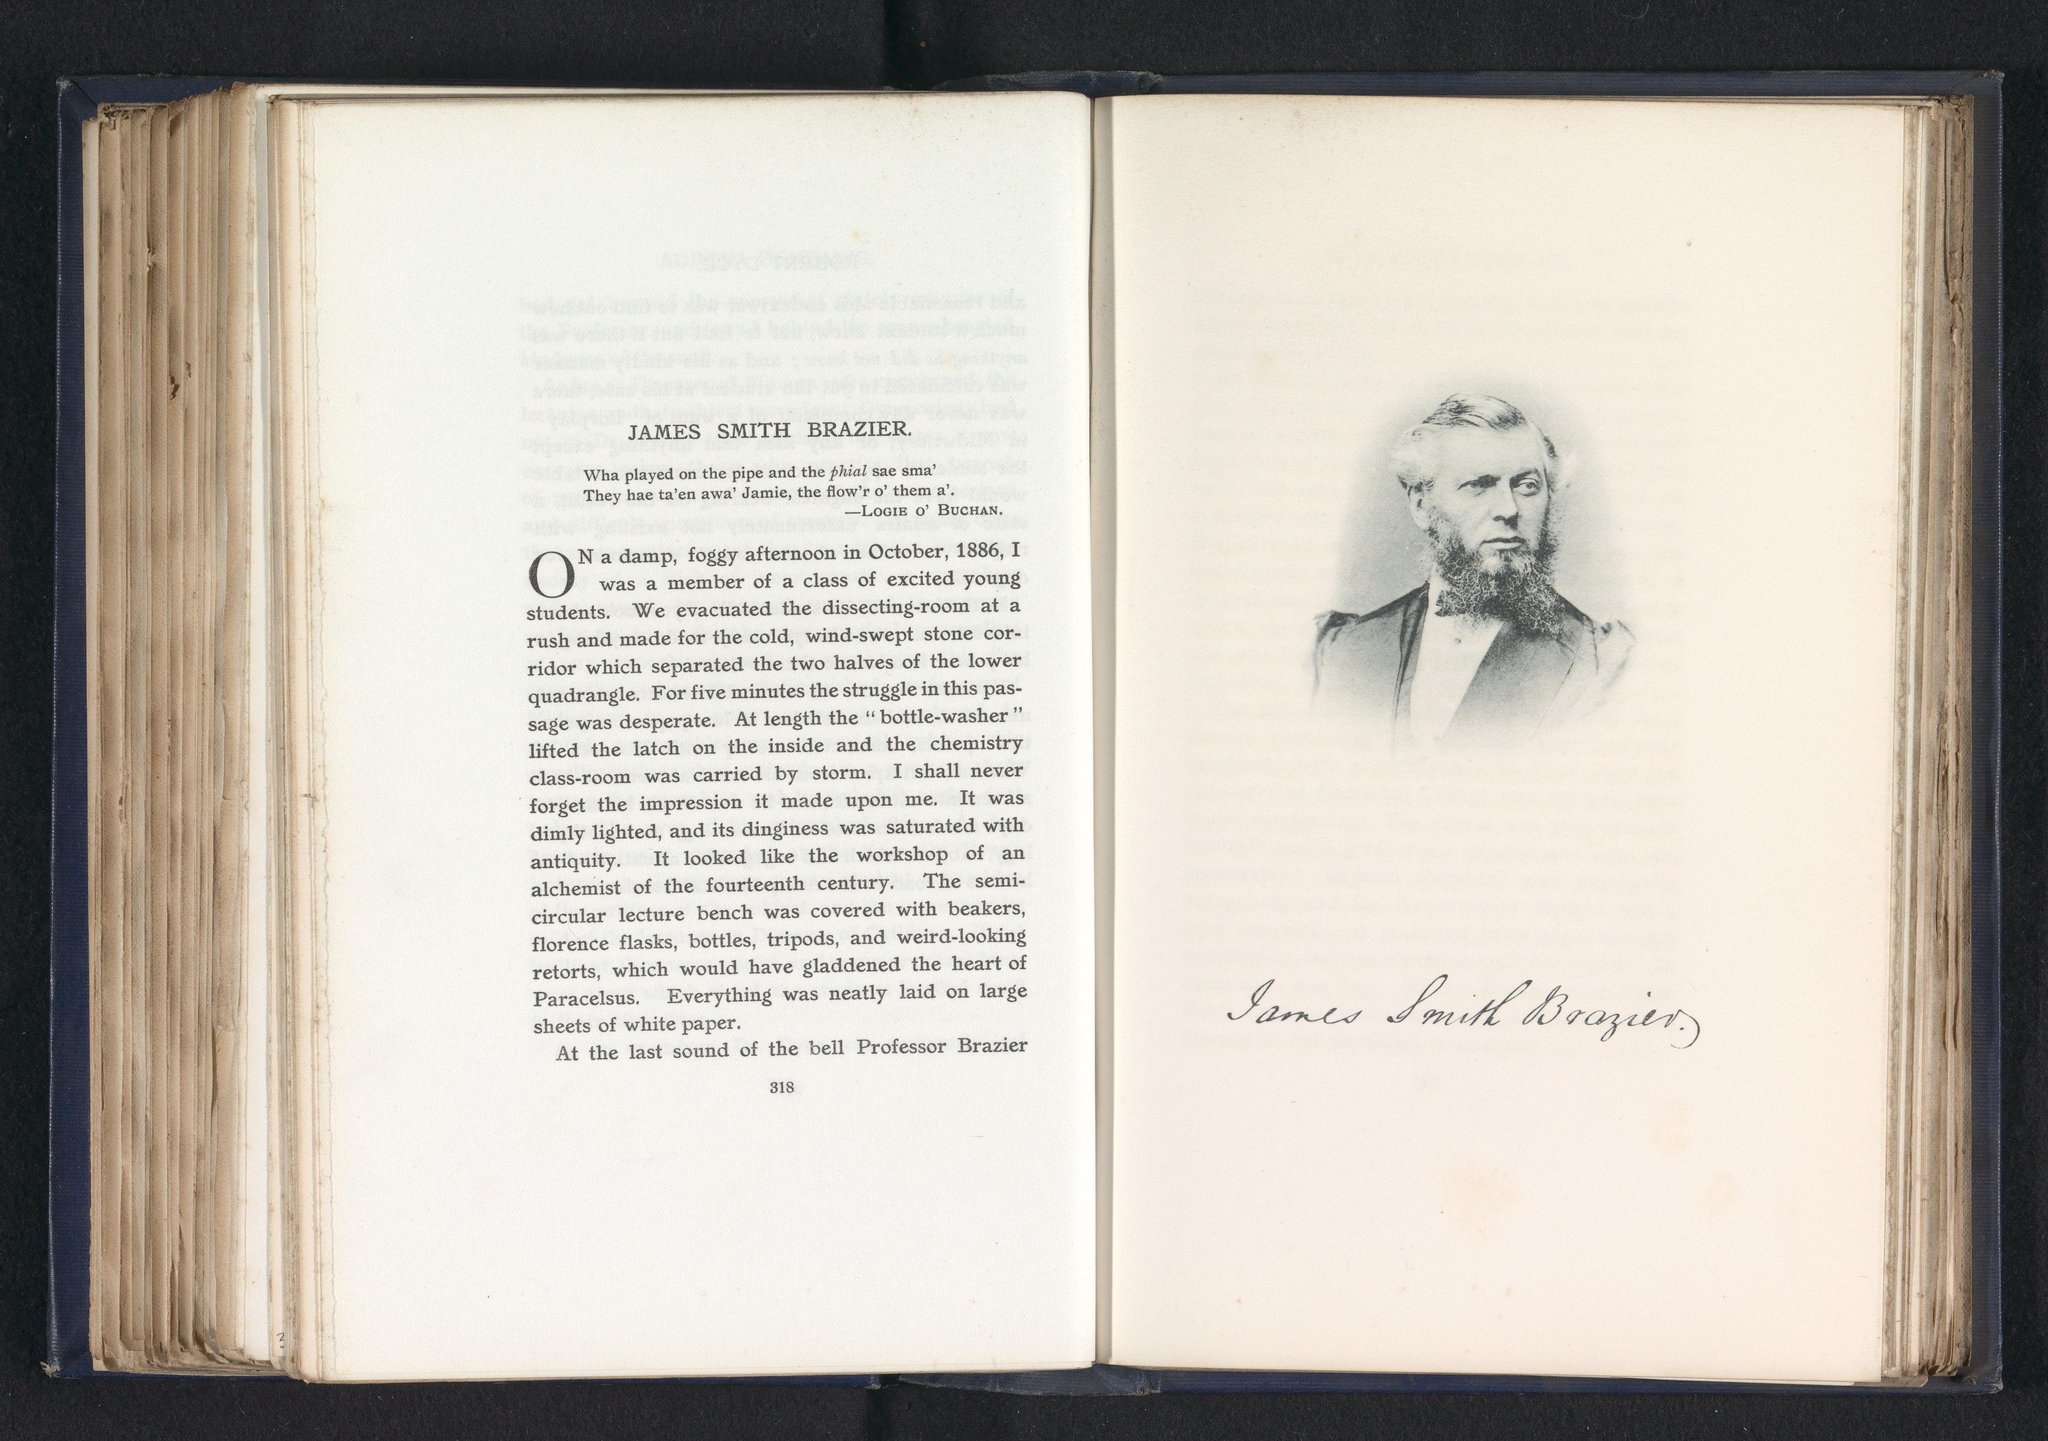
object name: photomechanical print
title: James Smith Brazier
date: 1889-1899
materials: paper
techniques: photograph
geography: aberdeen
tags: scholar, philosopher